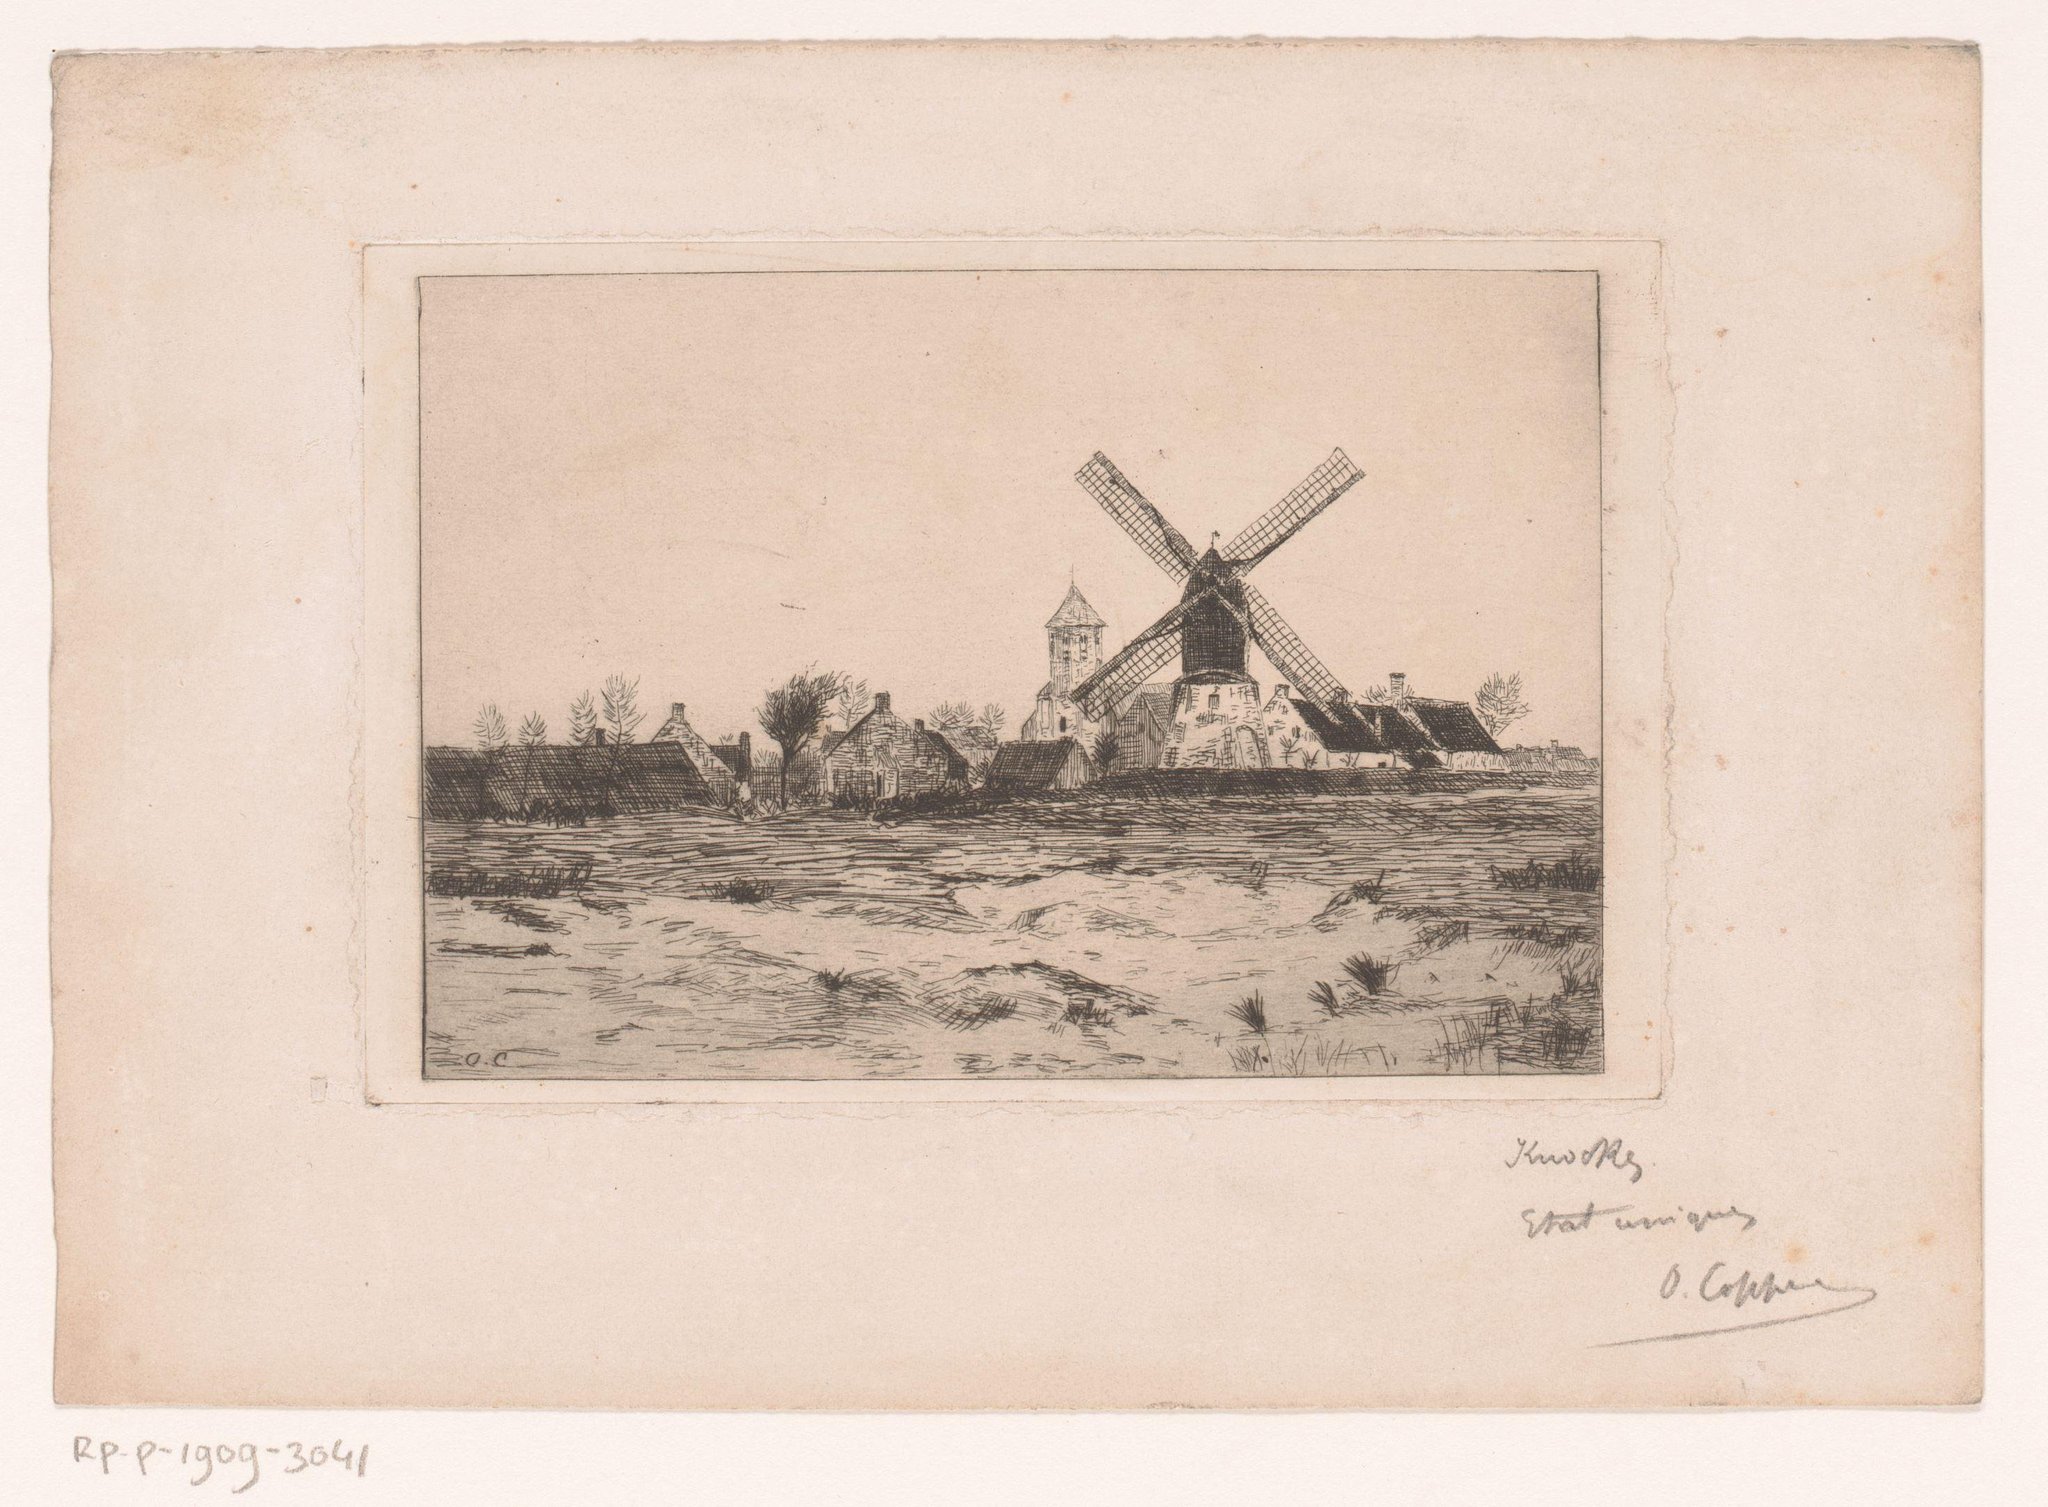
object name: print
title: Gezicht op een dorp met molen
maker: omer coppens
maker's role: print maker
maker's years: 1864-1926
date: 1874-1909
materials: paper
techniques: etching, intaglio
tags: prospect of village, silhouette of village, windmill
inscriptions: inscription: ‘9 vue d'un village hollandais’, collector's mark: Lugt 2228, inscription: ‘(...) Etat unique’